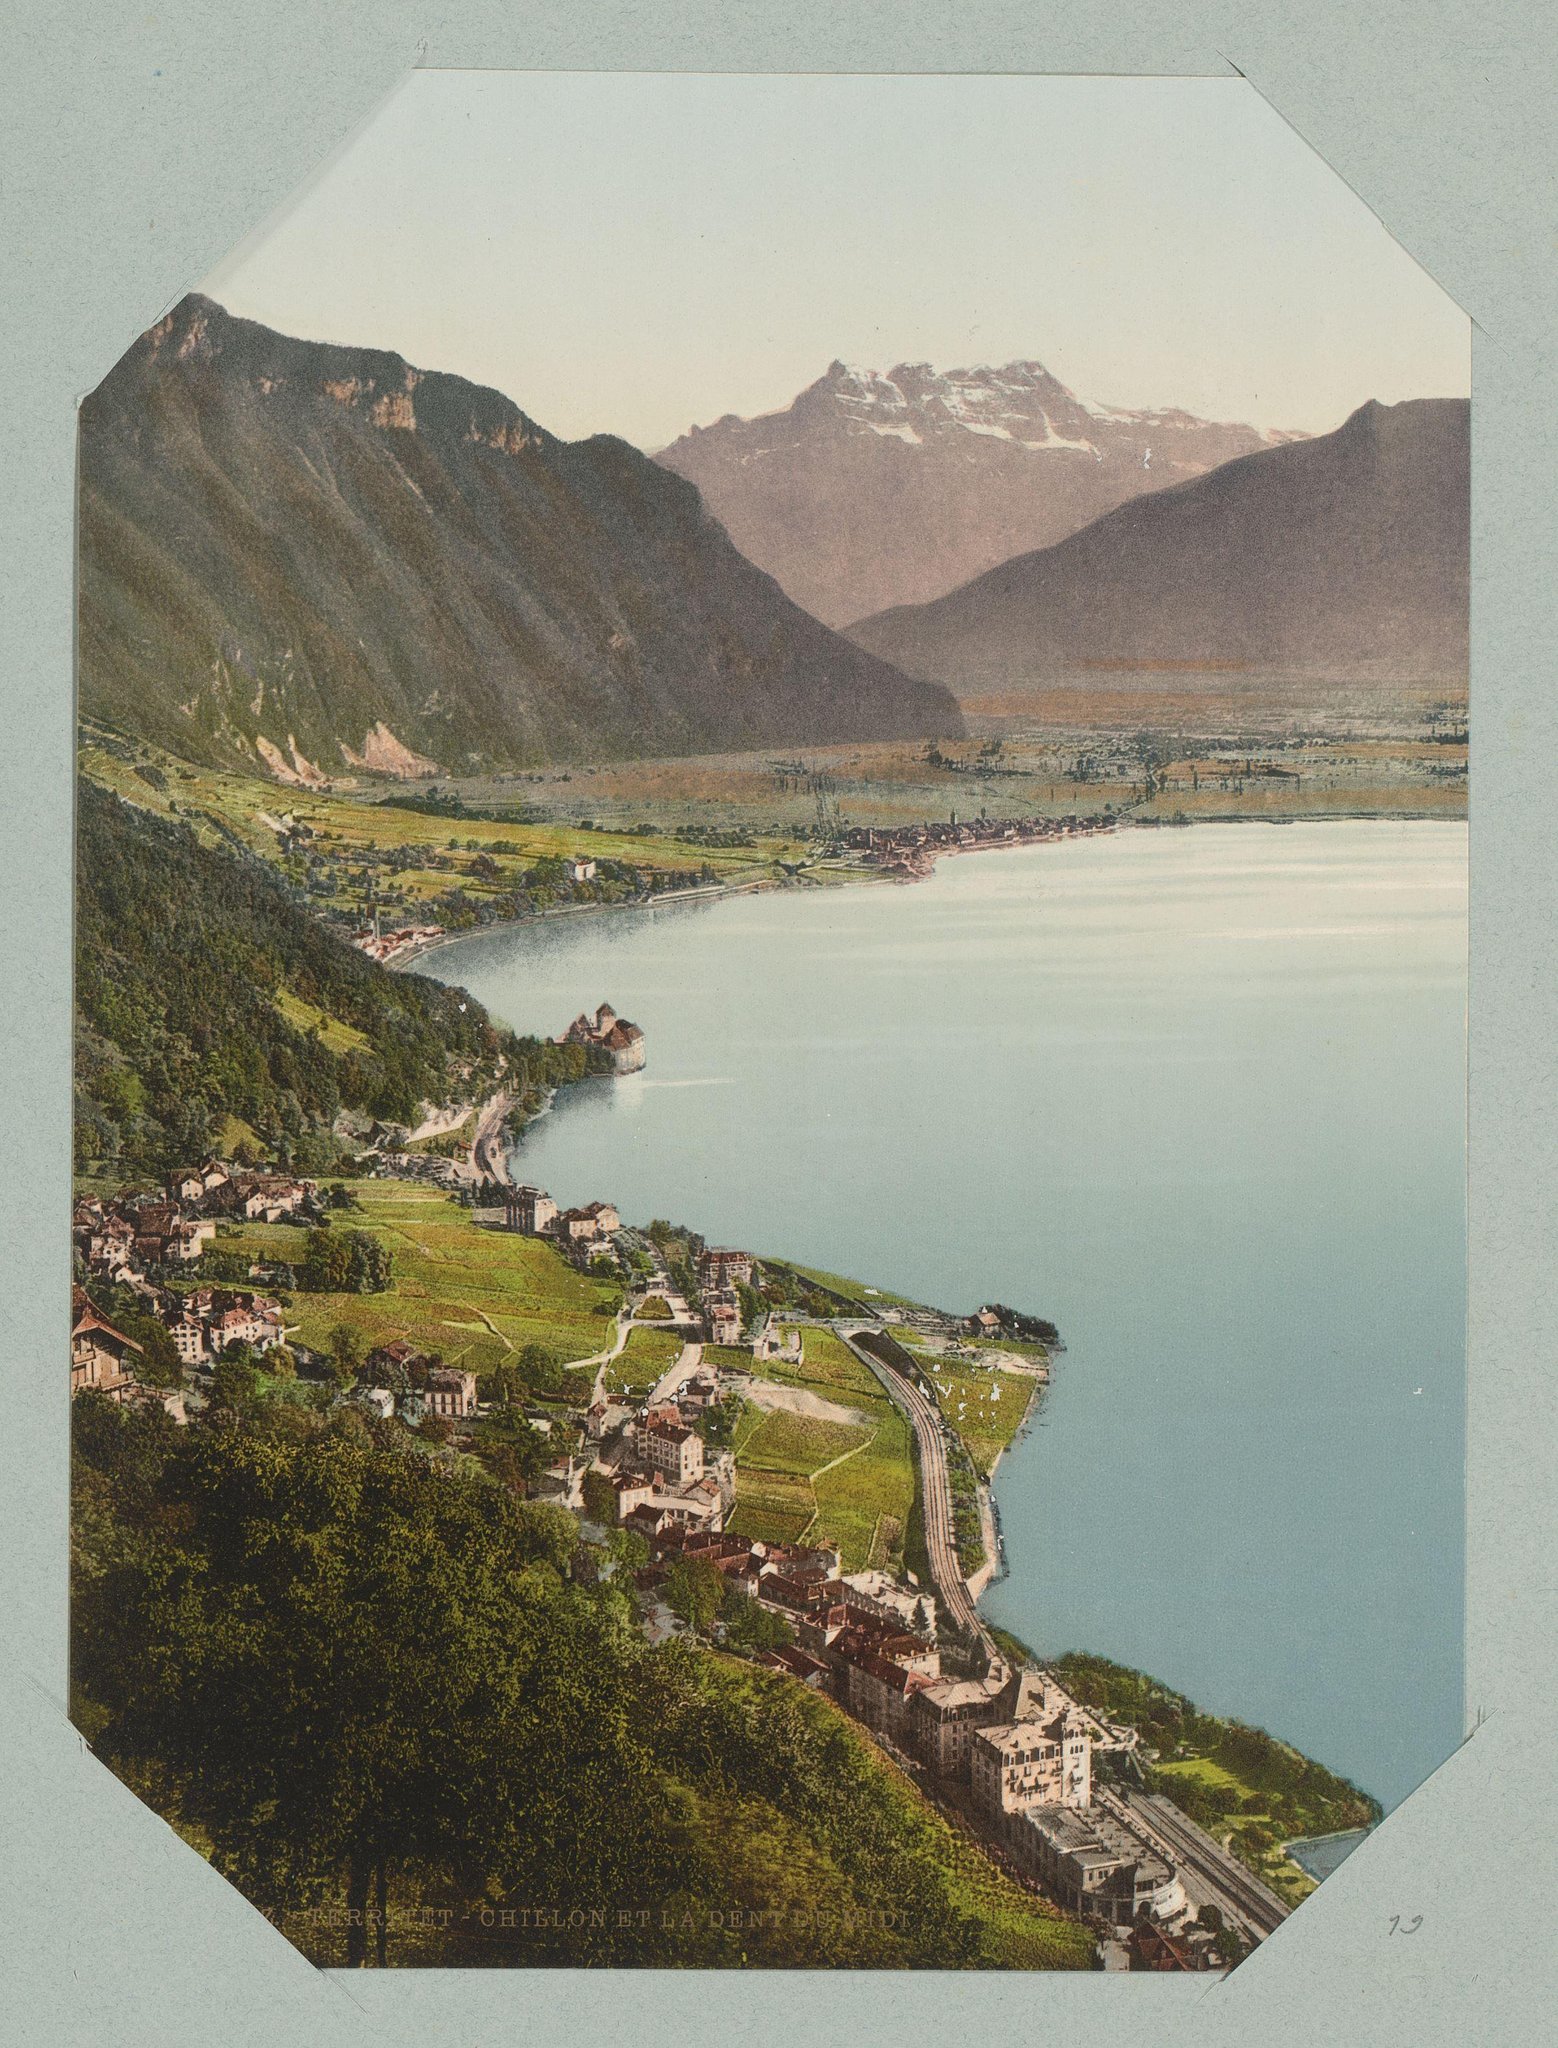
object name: album leaf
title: Gezicht op het kasteel van Chillon, het meer van Genève en de Dents du Midi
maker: Anonymous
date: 1889-1900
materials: paper, photographic process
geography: zurich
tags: lake, mountains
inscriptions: retailer's mark: ‘Sabin-Girod/ 2, Place Cornavin/ Succursale/ 14, Rue du Mont-Blanc/ Genève’, inscription: ‘6893. P.Z.- Territet - Chillon et la Dent du Midi’, inscription: ‘Photochrom’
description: Deze prent maakt deel uit van een album.